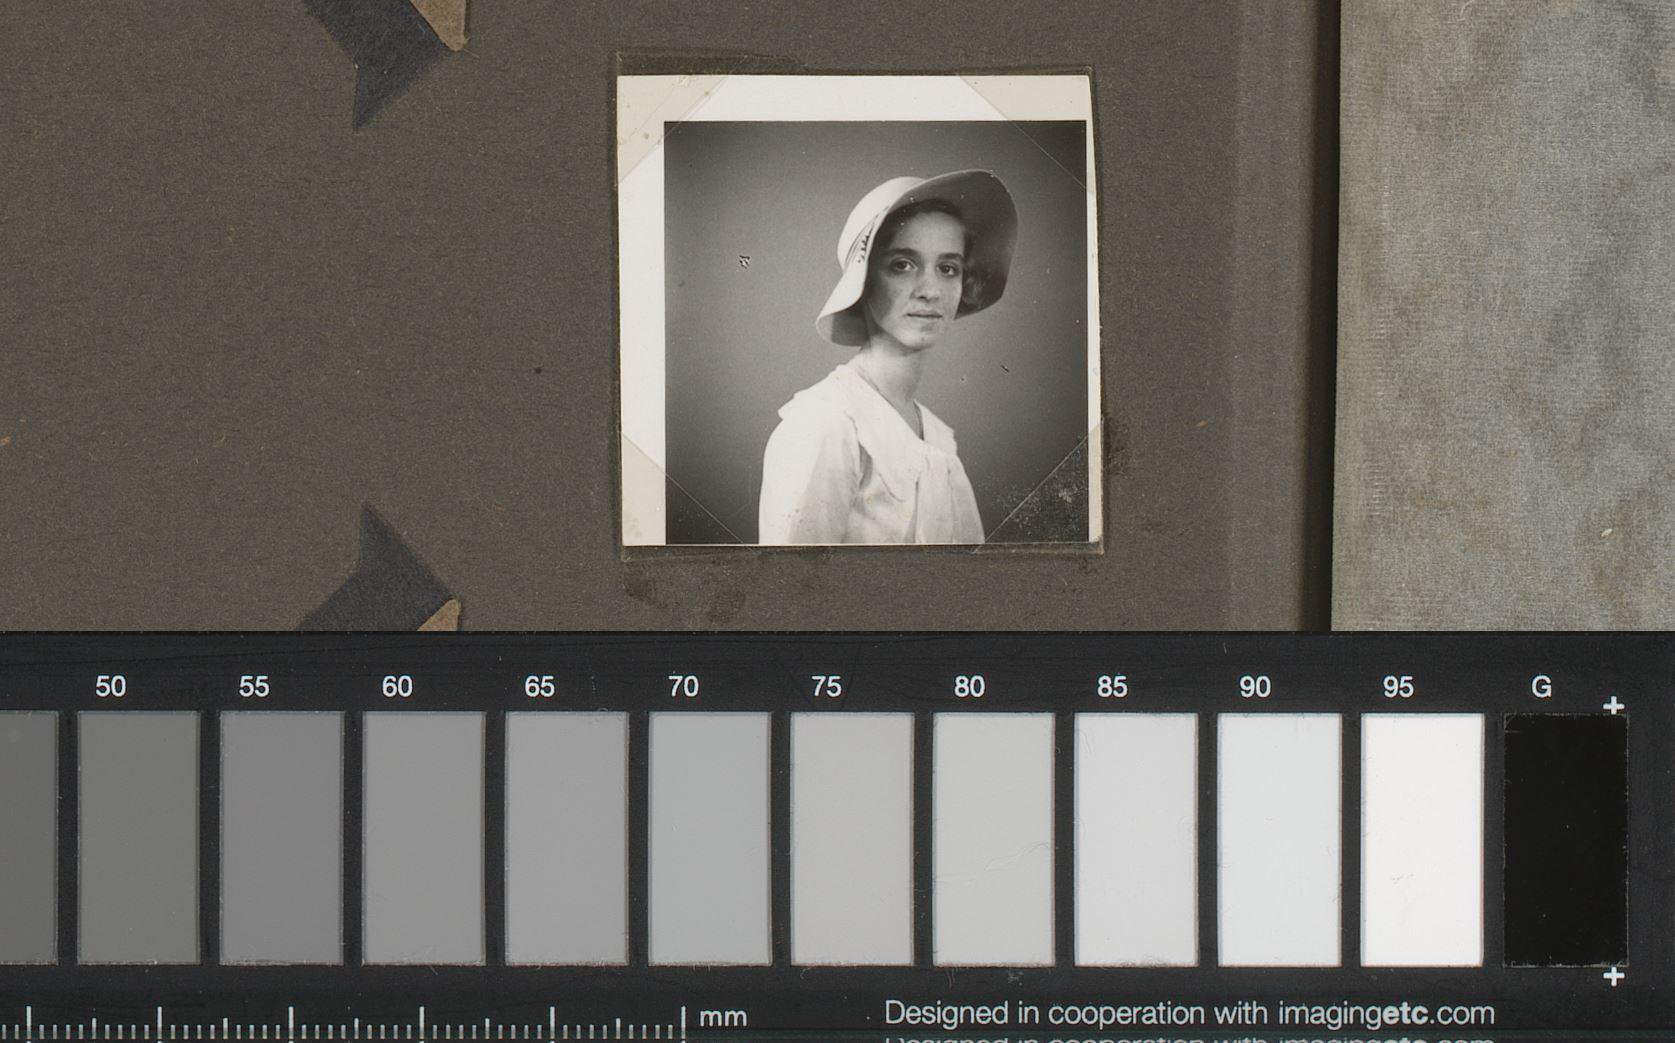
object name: photograph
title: Portret van een vrouw met hoed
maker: Anonymous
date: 1920-1940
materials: photographic support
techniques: gelatin silver print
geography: netherlands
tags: historical persons - bb - woman, head-gear: hat